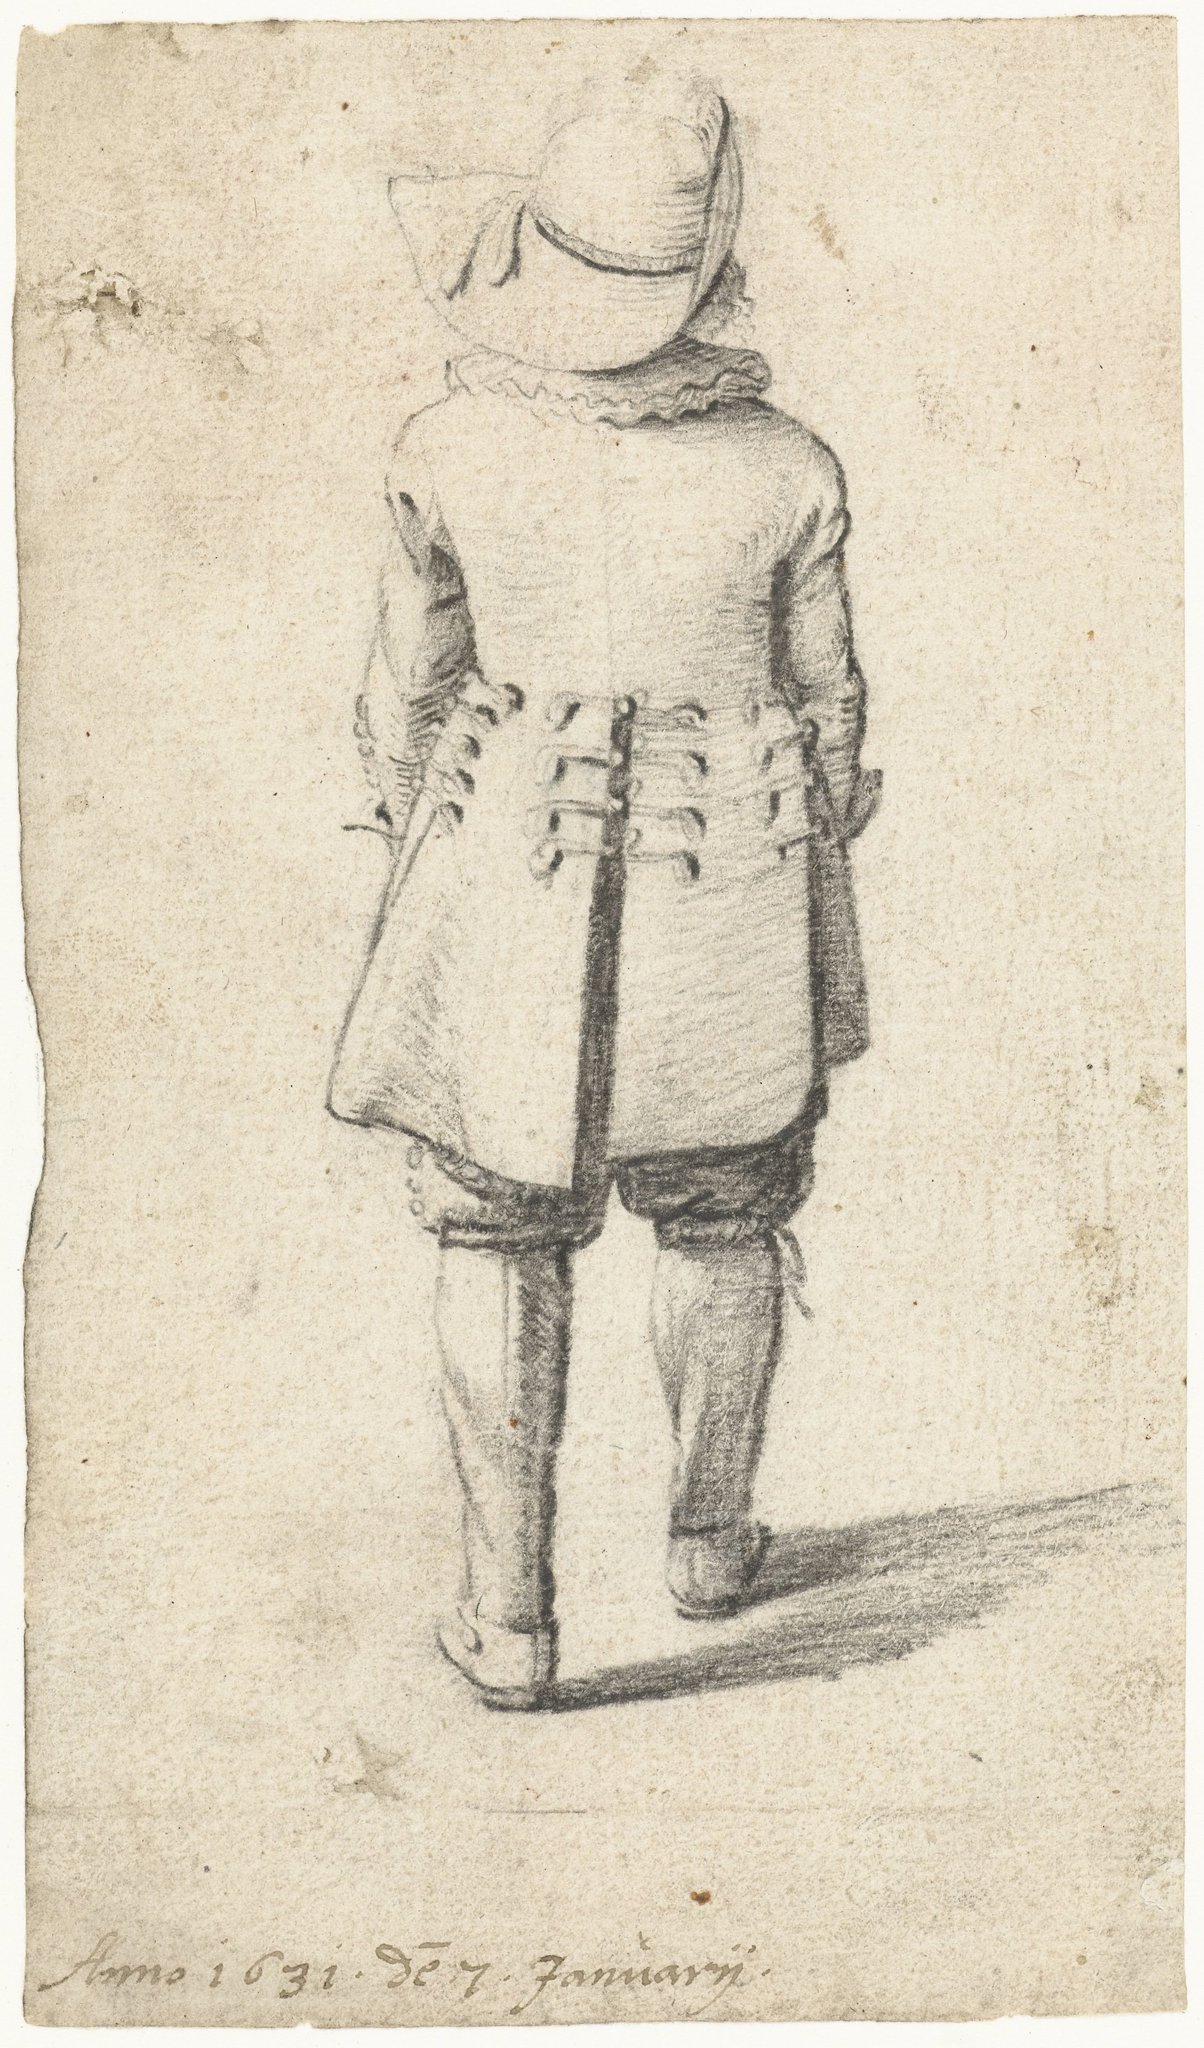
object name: drawing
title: Staand jongetje, van achteren gezien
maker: gerard ter borch (ii)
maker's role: draughtsman, painter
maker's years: 1617-1681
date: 1631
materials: chalk, paper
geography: zwolle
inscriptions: date: ‘Anno 1631. den 7 Januarij’